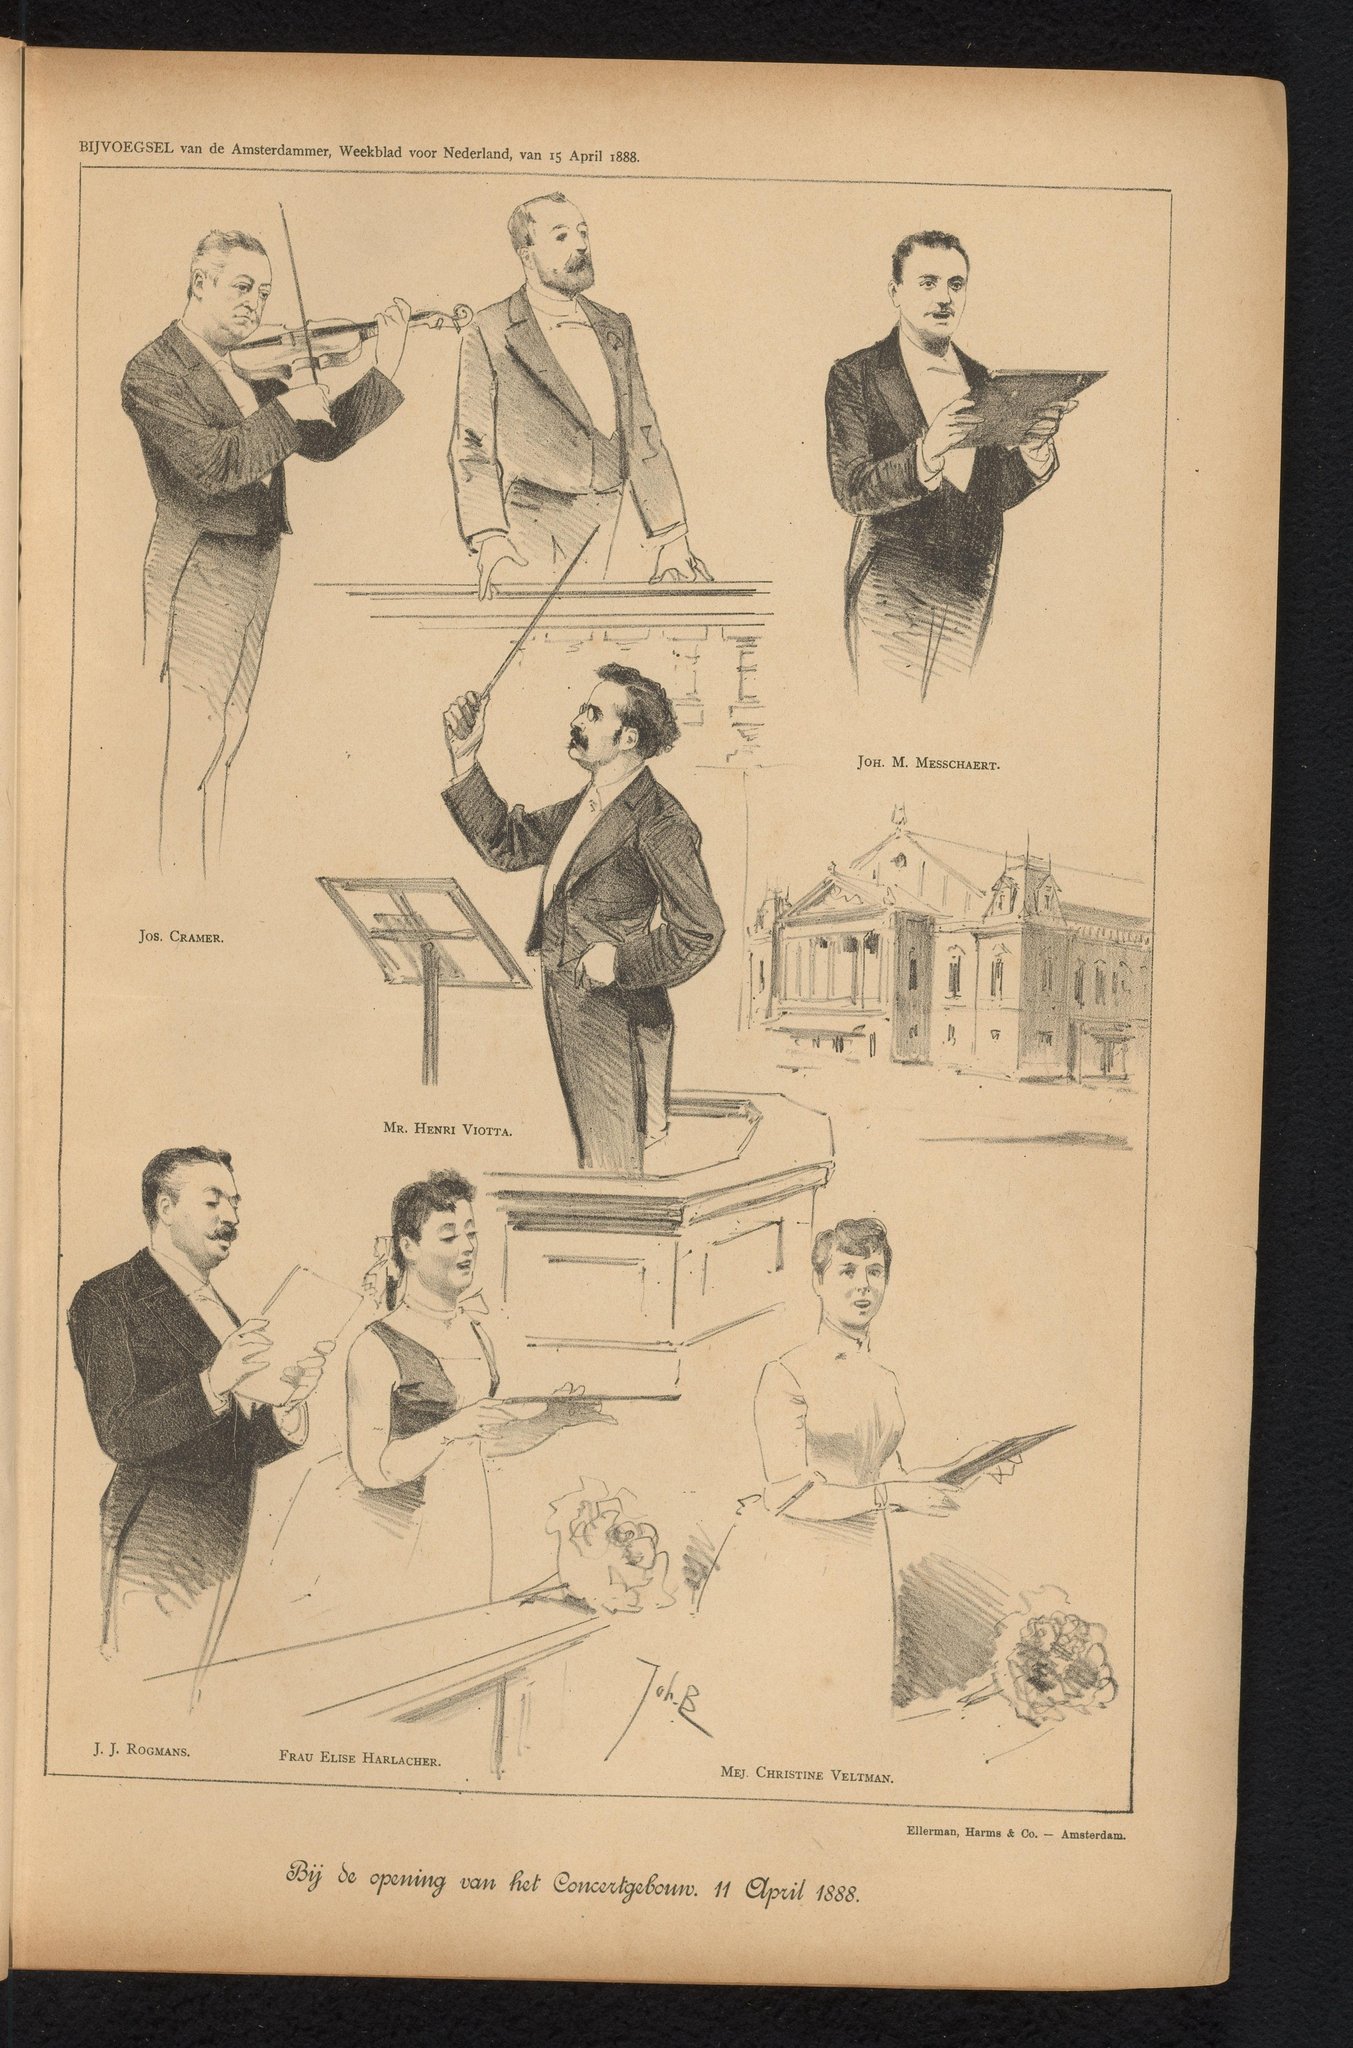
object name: print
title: Bij de opening van het Concertgebouw. 11 April 1888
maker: johan braakensiek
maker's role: draughtsman, print maker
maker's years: 1858-1940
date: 1888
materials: paper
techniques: lithograph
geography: netherlands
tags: hoorn (north holland), johannes martinus messchaert, haarlem, amsterdam, historical persons - bb - woman, historical persons, opera-singer (female), opera-singer (male), conductor ~ music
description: Dirigent Viotta, violist Cramer en verschillende zangers en zangeressen die optraden bij de opening van het Concertgebouw op 11 april 1888. Ook met een gezicht op het Concertgebouw.